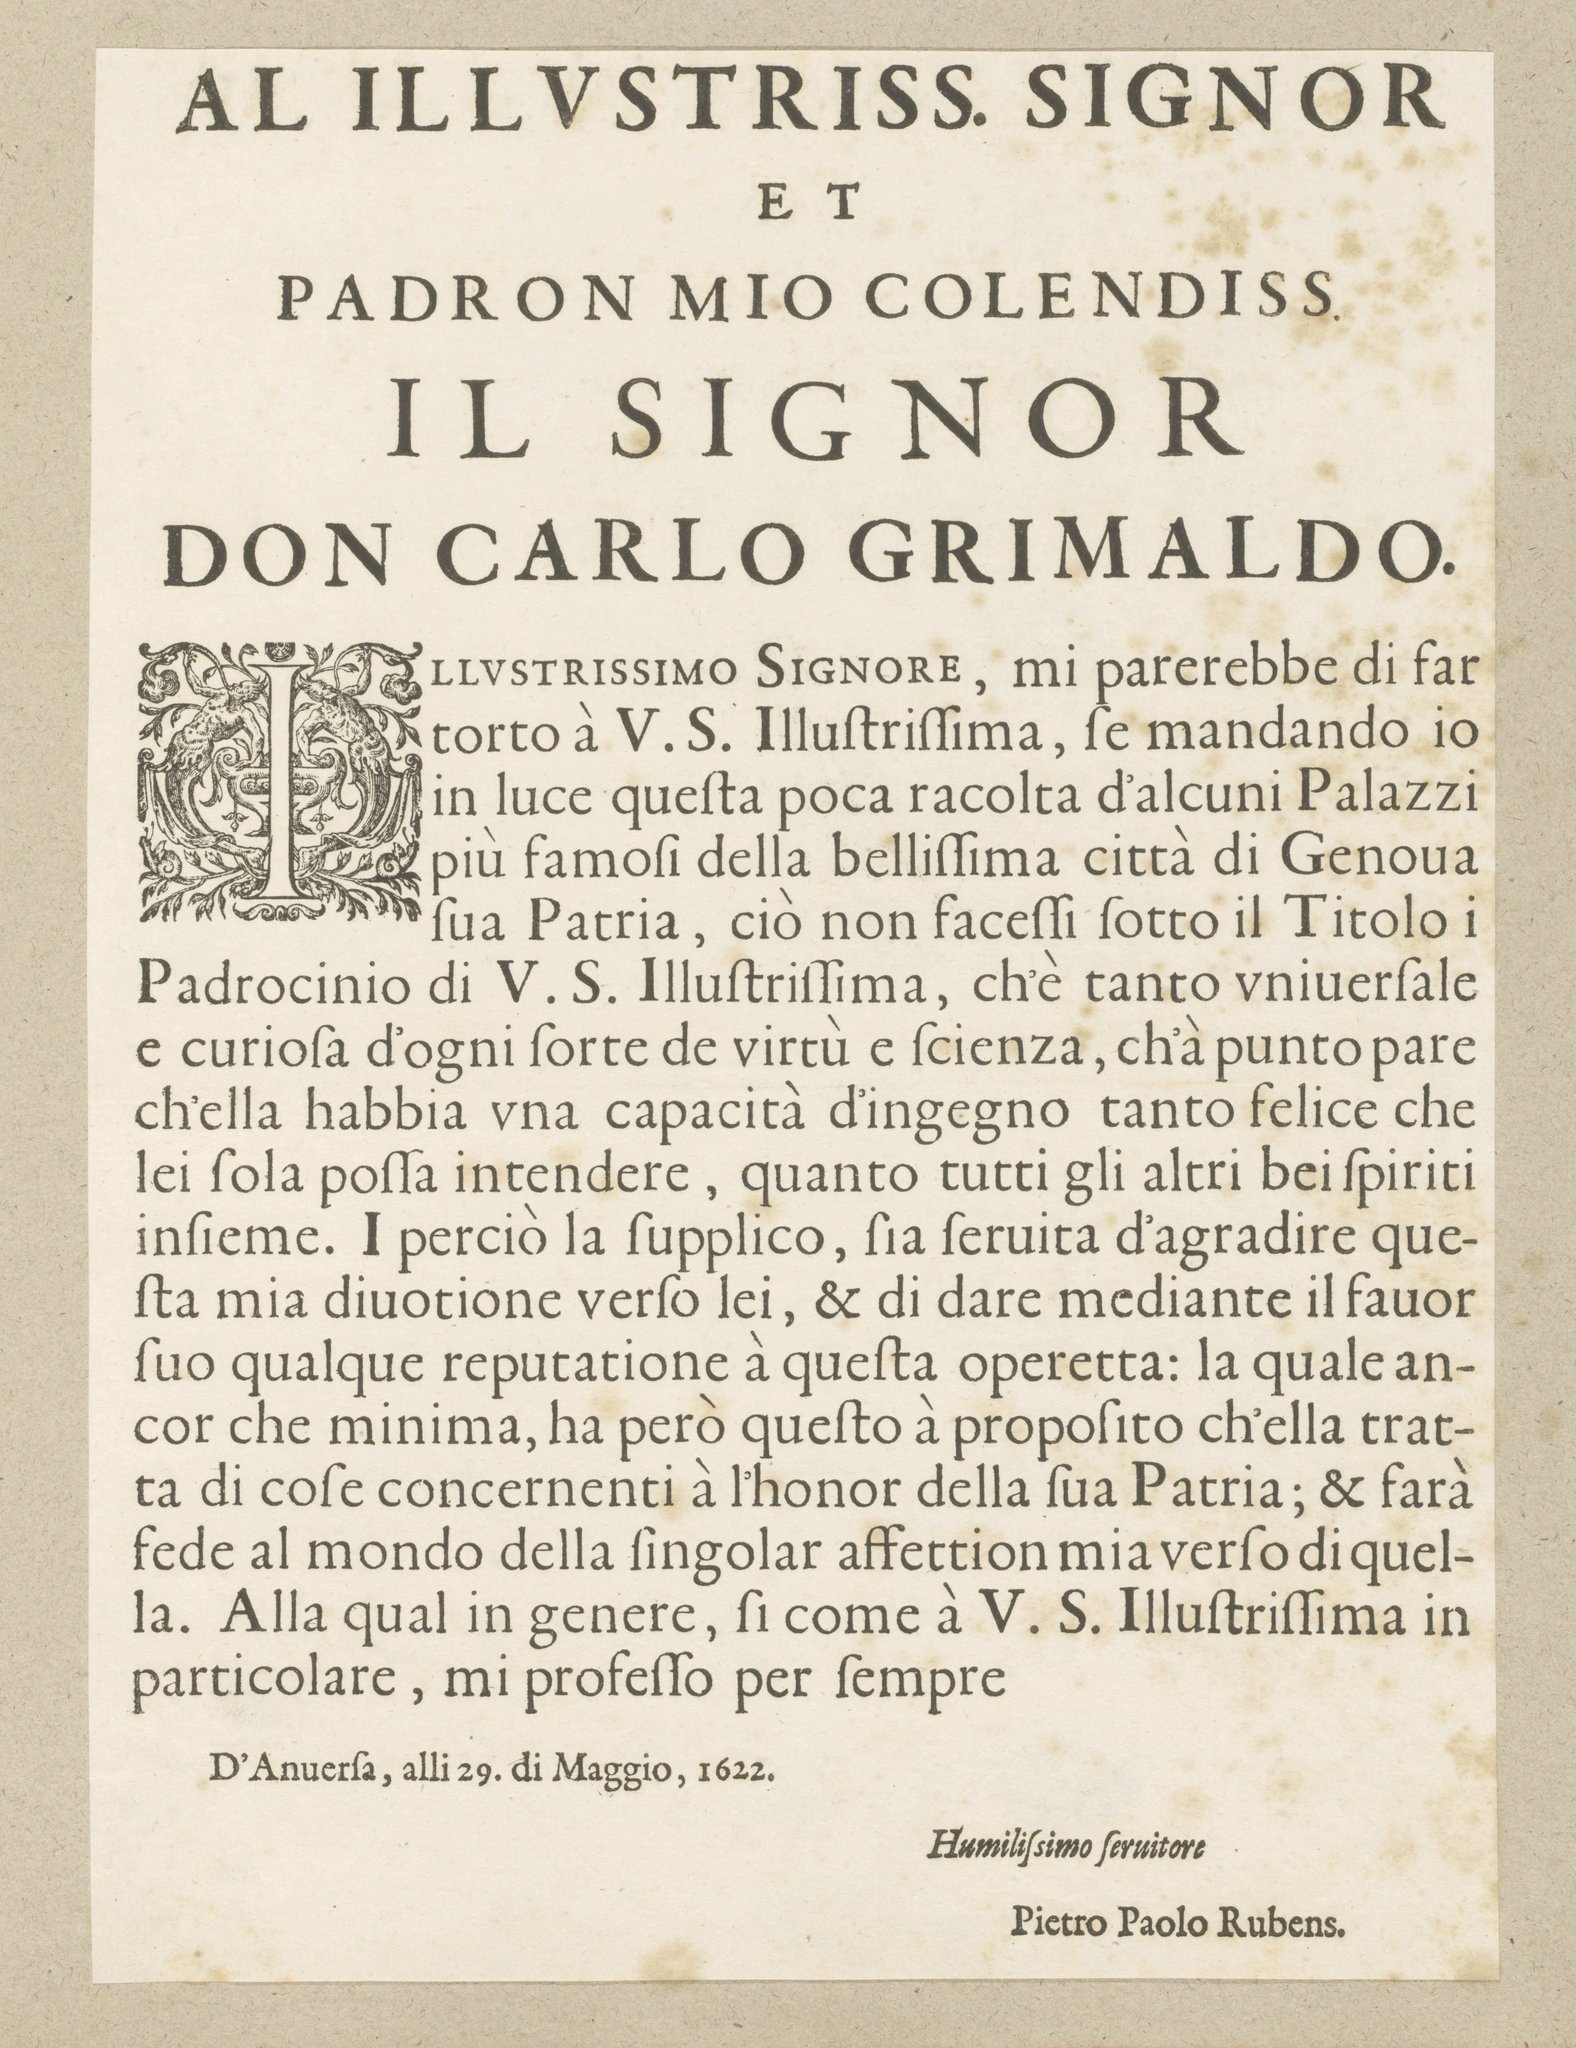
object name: print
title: Opdracht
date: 1622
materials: paper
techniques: letterpress printing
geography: antwerp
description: Deze prent maakt deel uit van een album.